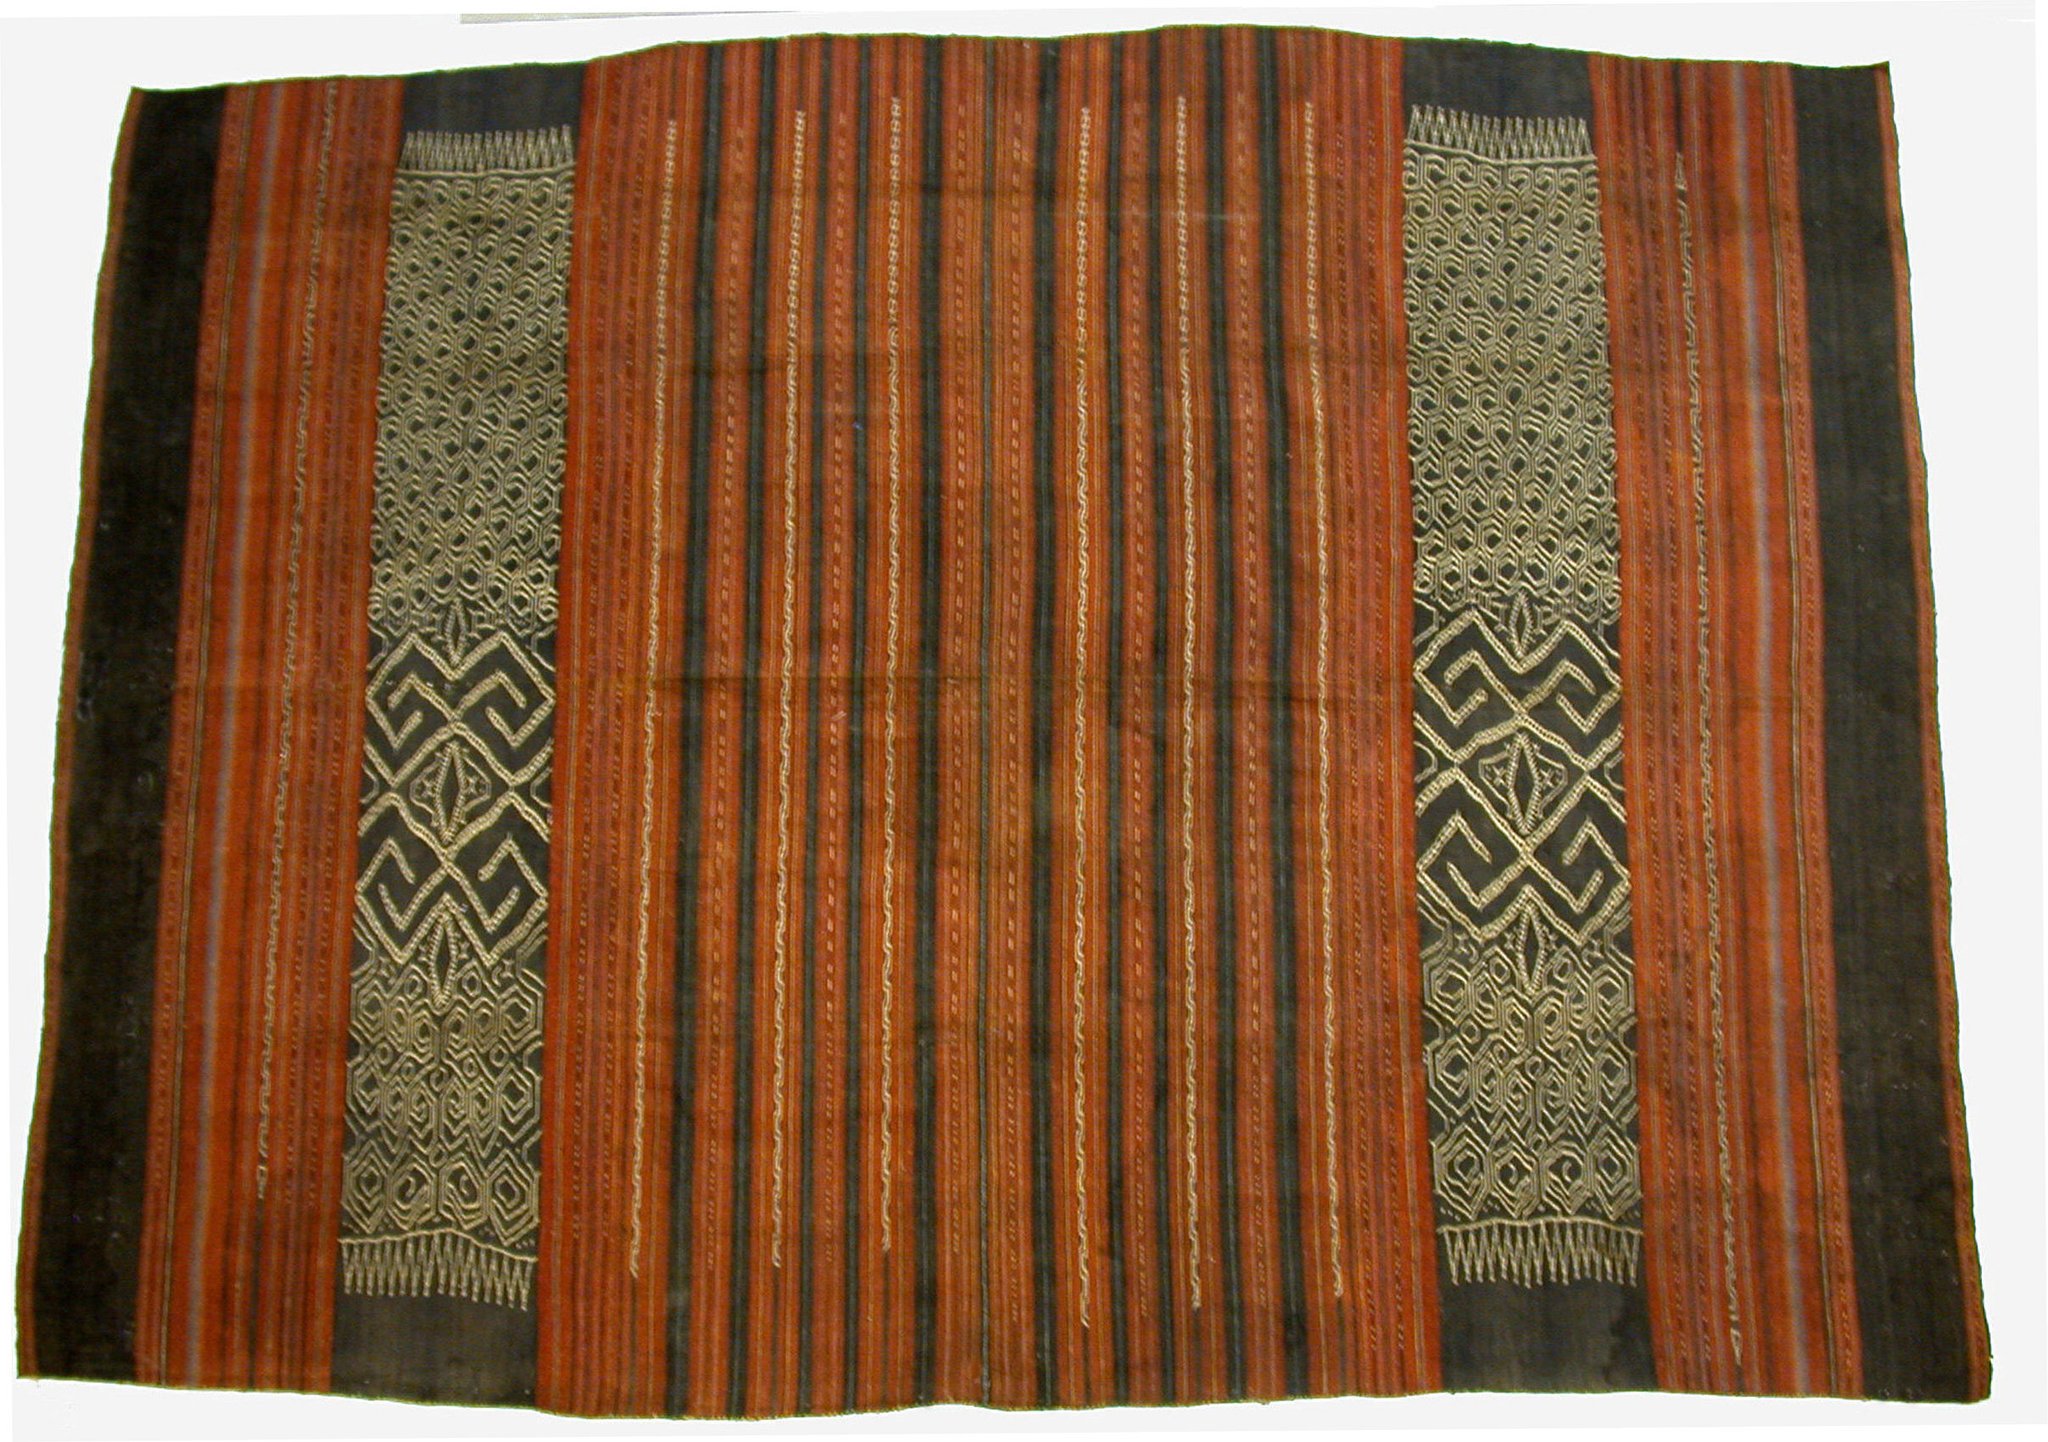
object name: skirt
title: Woman's Ceremonial Skirt (Sora Langi')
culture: toraja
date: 1701-1800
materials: cotton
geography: indonesia